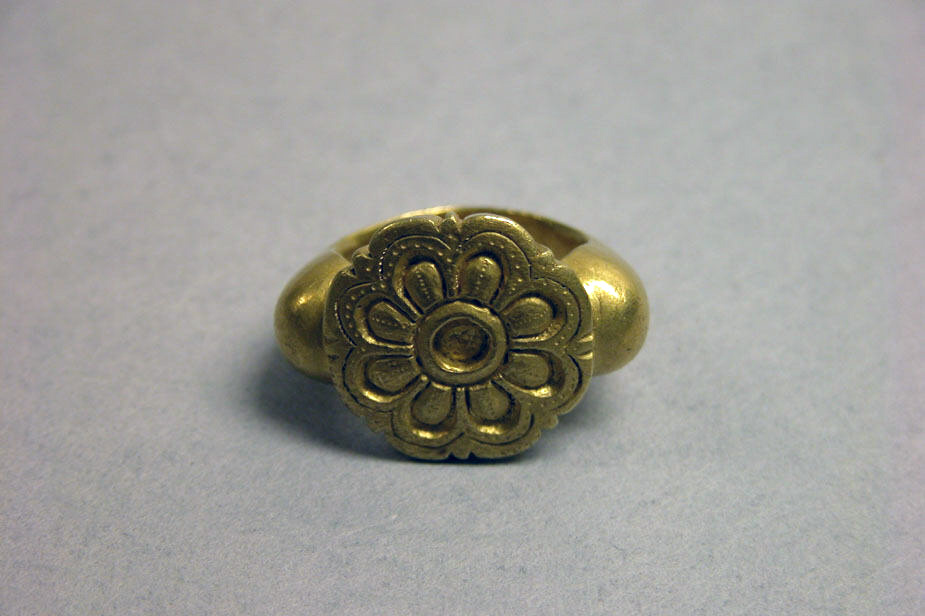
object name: ring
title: Stirrup-shaped Ring with Lotus Pattern on Bezel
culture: indonesian, javanese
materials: gold